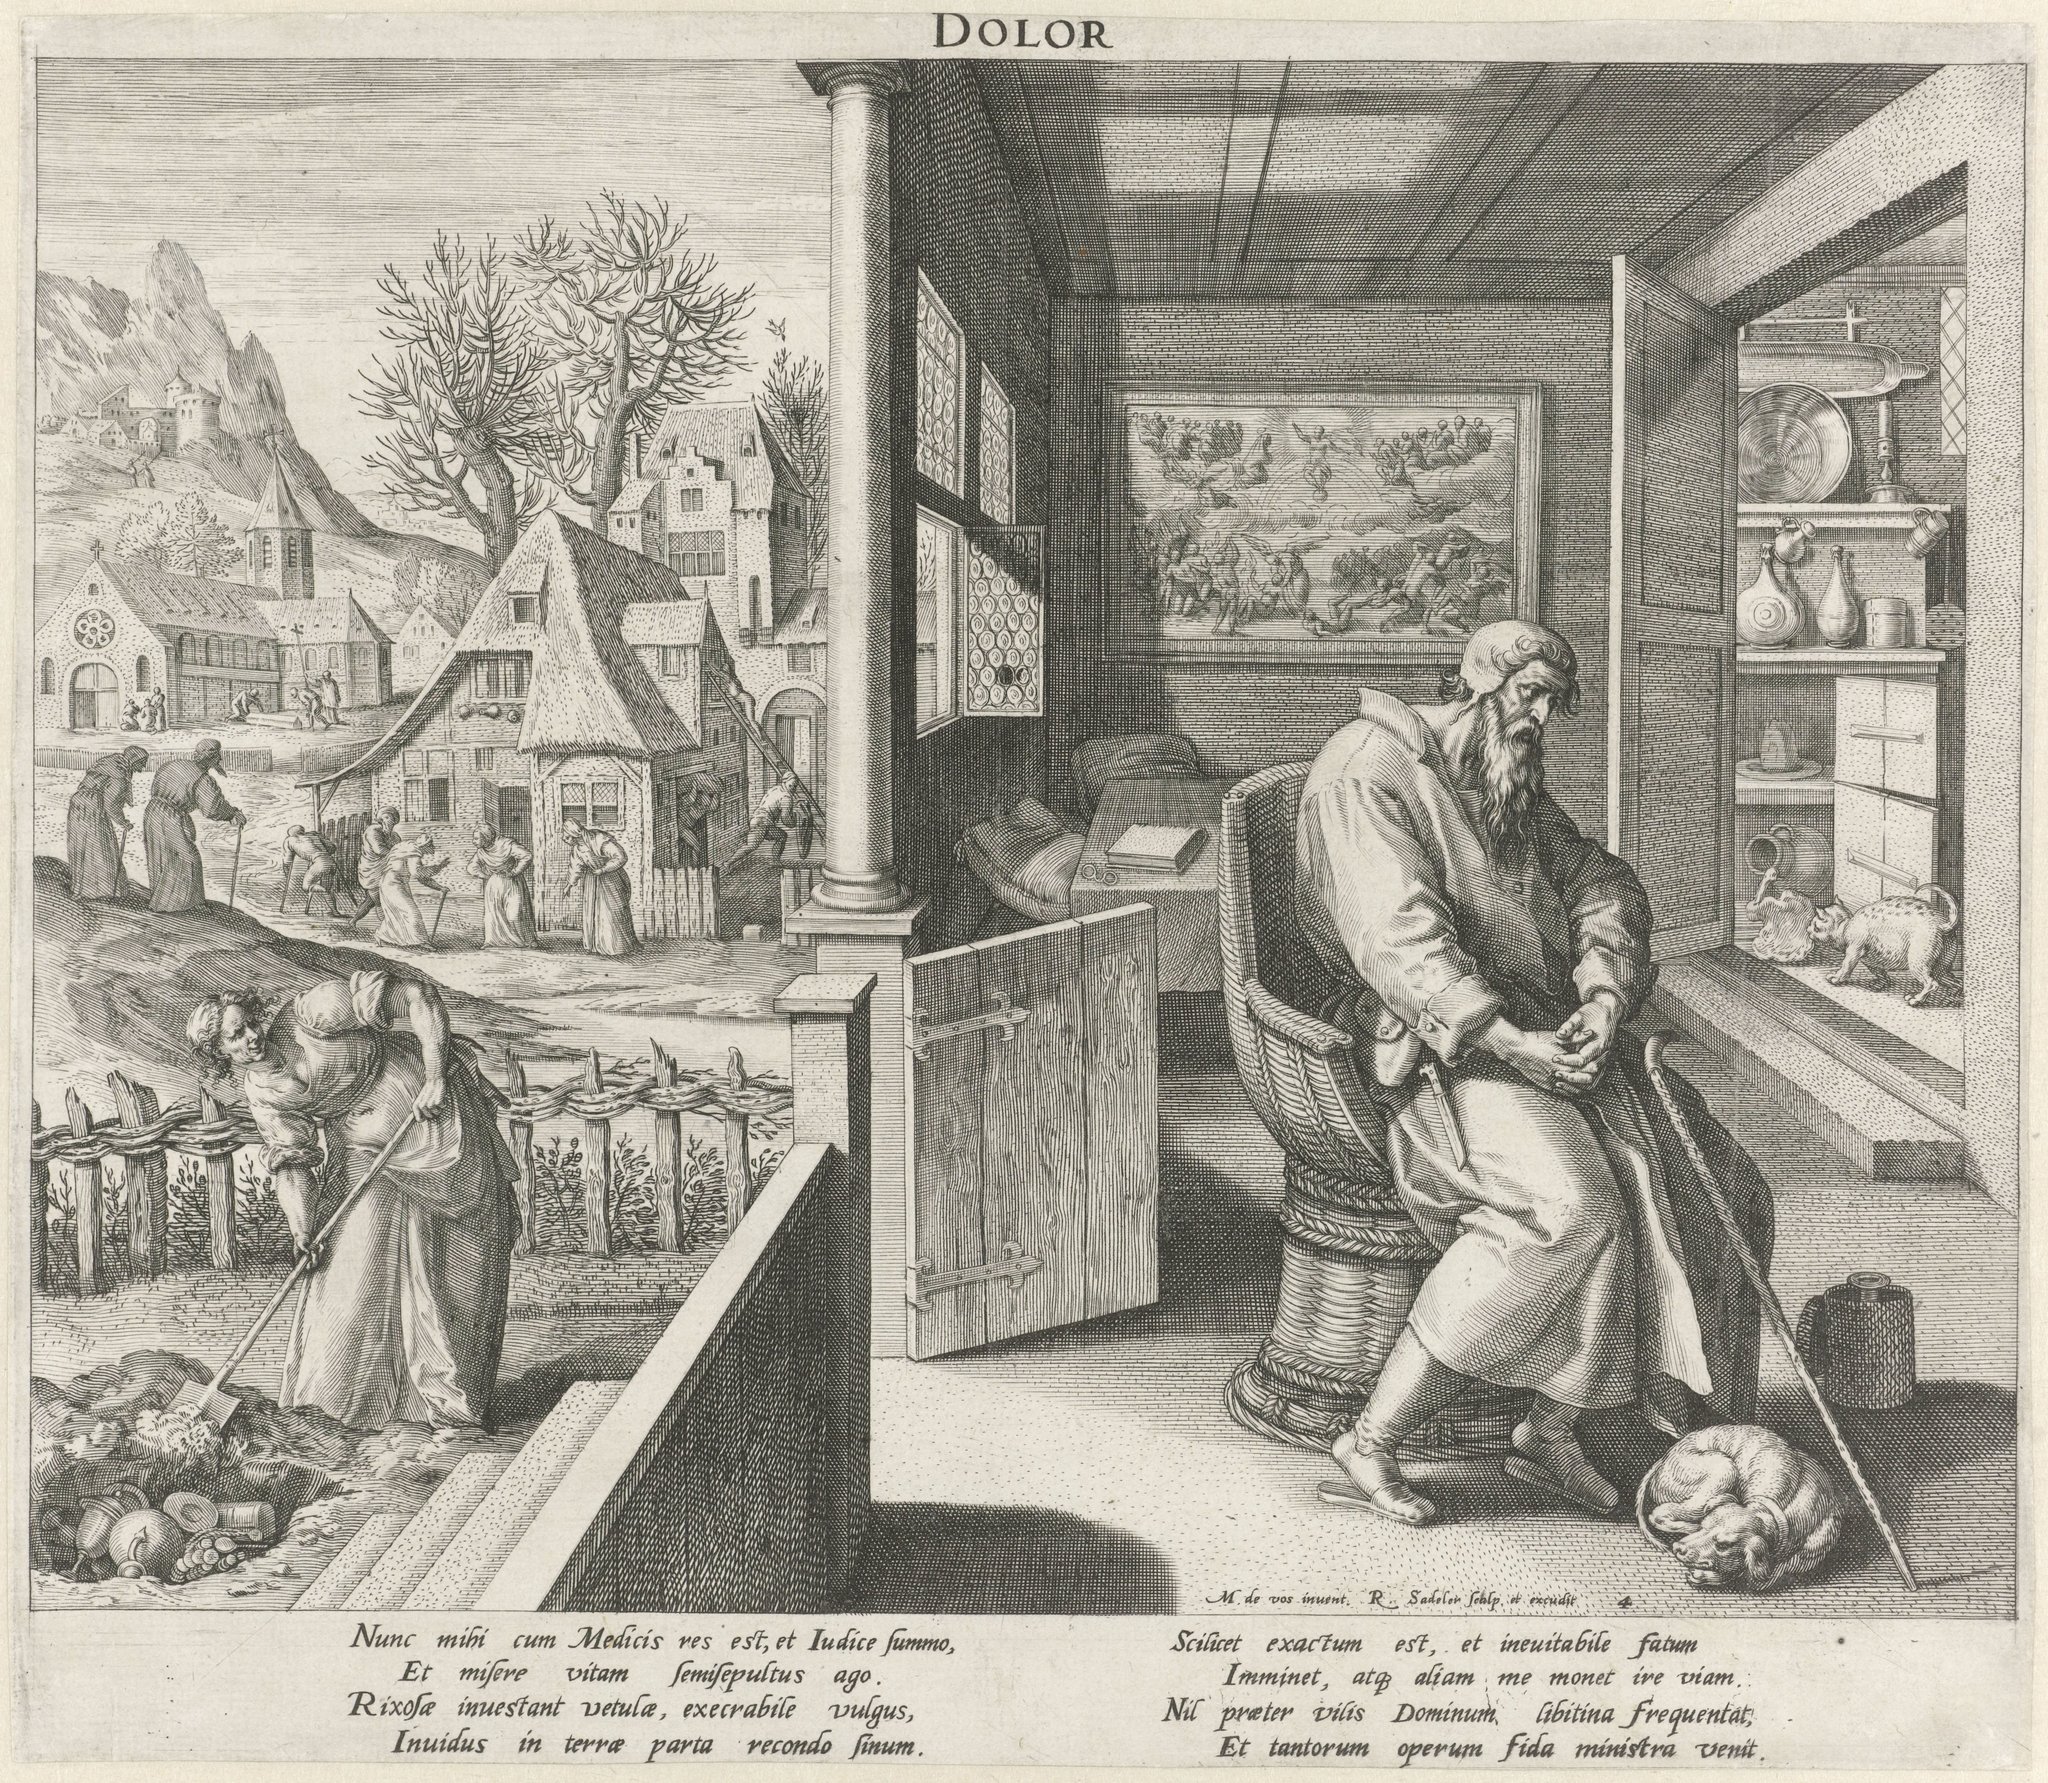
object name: print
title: De vier leeftijden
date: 1591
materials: paper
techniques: engraving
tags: burial, old age, 'senectus'; 'vecchiezza' (ripa), last judgement, painting (including book-illumination, miniature-painting), quarrel, argument, hiding, concealing, burying a treasure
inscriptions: collector's mark: Lugt 2228, collector's mark: Lugt 2760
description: Een oude man zit in zijn kamer op een stoel en lijkt in gedachten verzonken. In de kamer hangt een schilderij van het Laatste Oordeel. Links, buiten het huis, begraaft een vrouw geld en sierraden in de tuin. Op de achtergrond links zijn enkele ouderen aan het ruziën en is er een begrafenis aan de gang nabij een kerk. Met Latijns onderschrift.